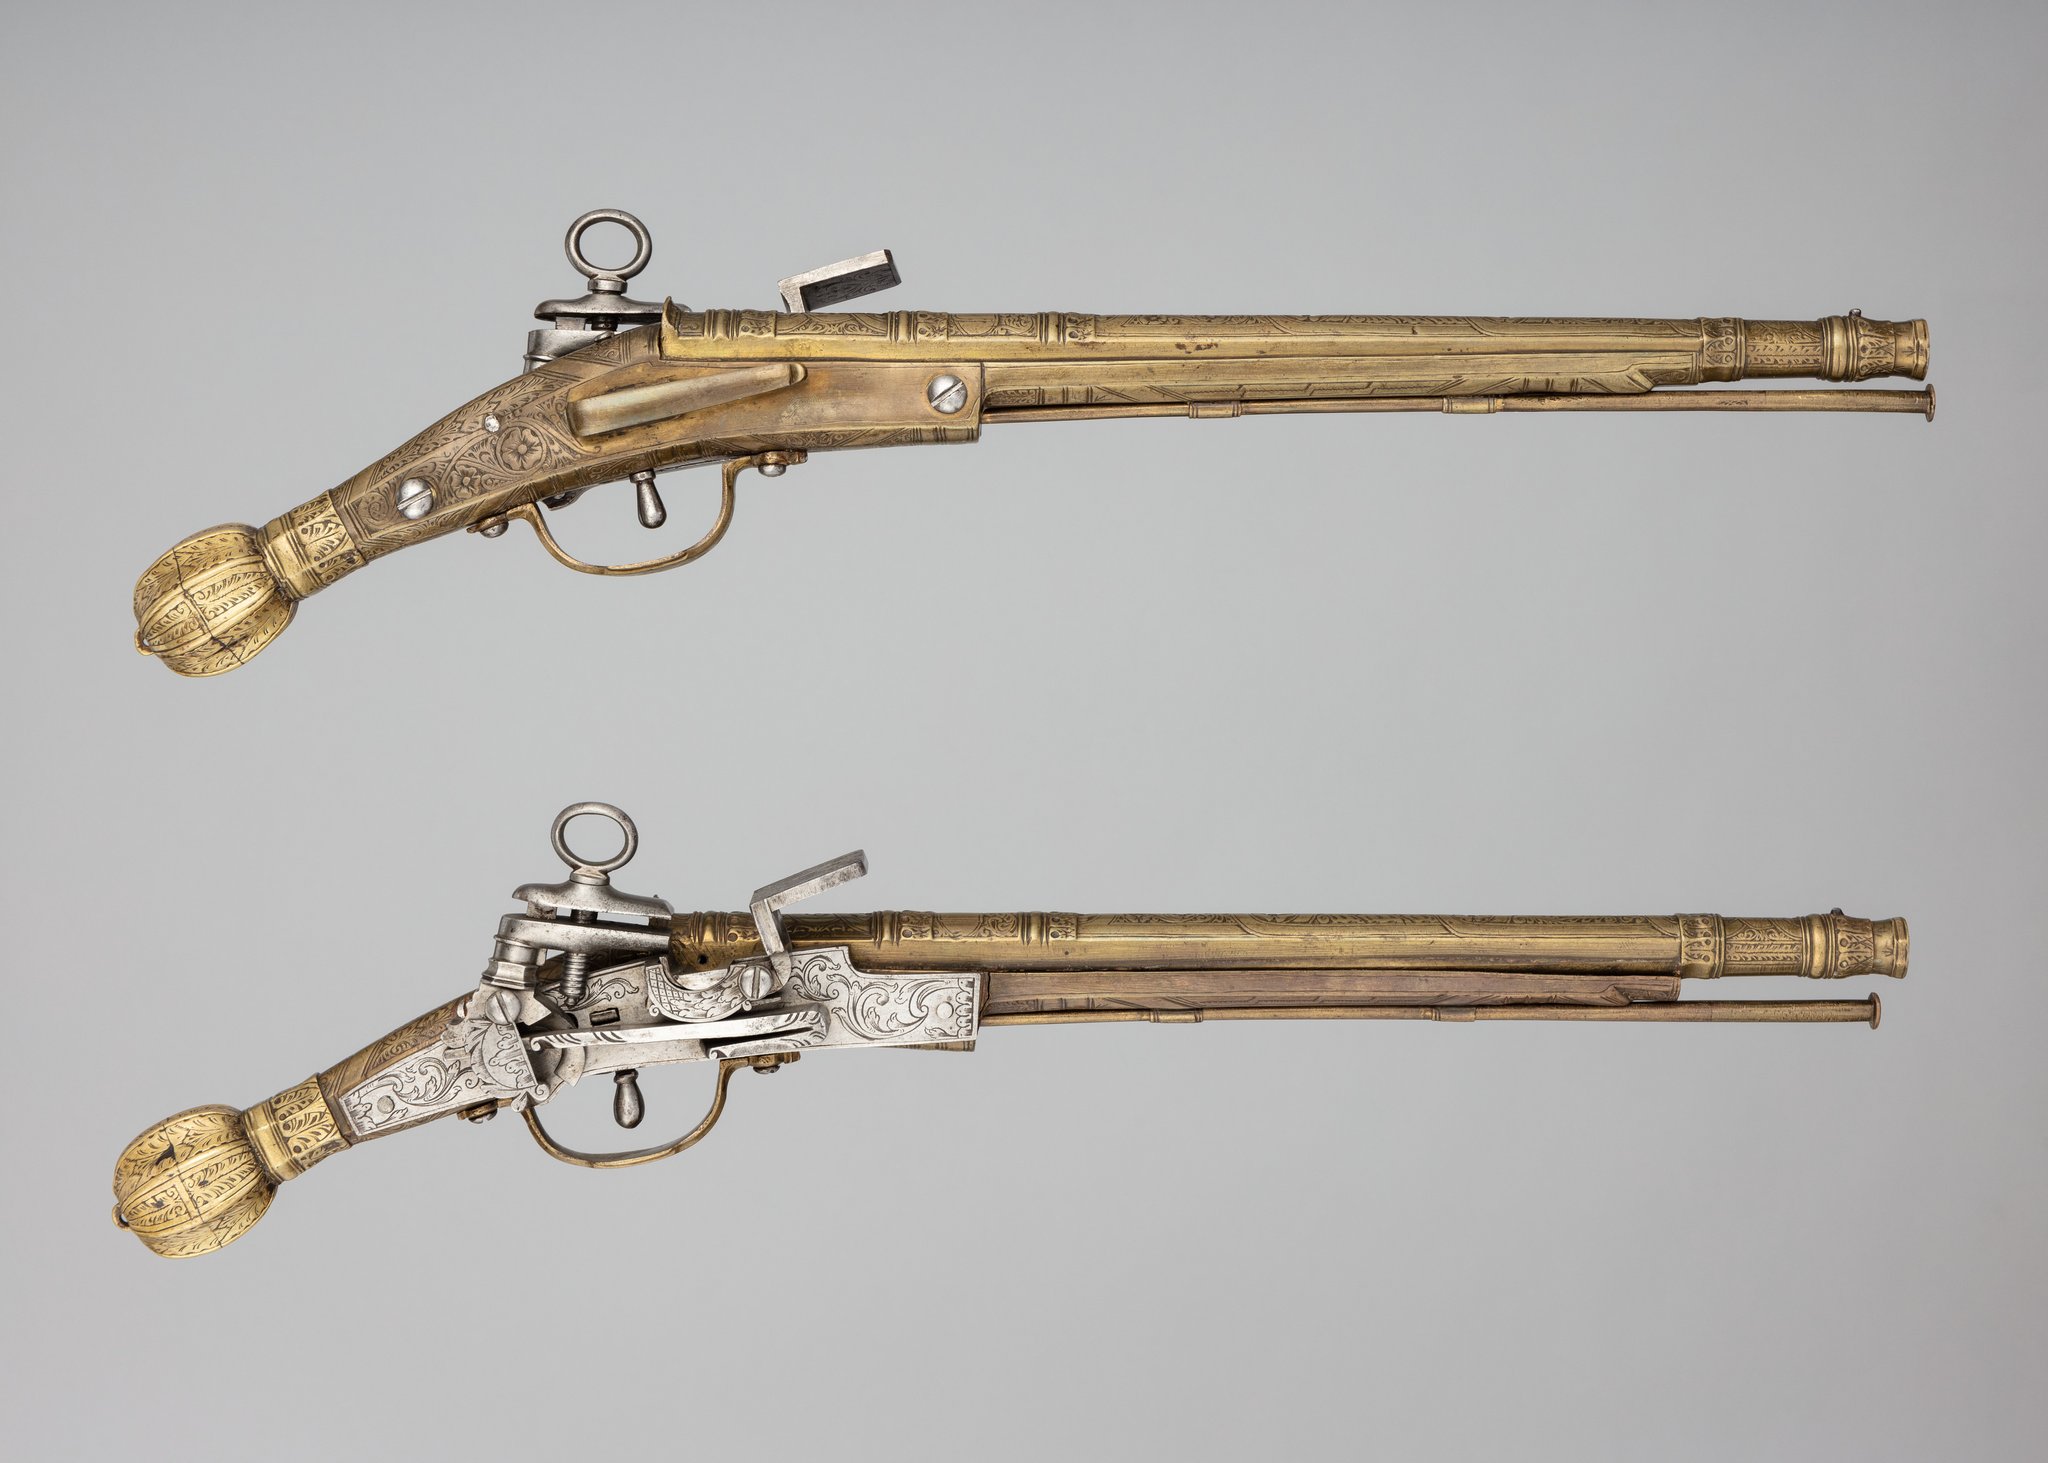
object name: pair of miquelet pistol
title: Pair of Miquelet Pistols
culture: scottish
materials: brass, steel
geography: scotland